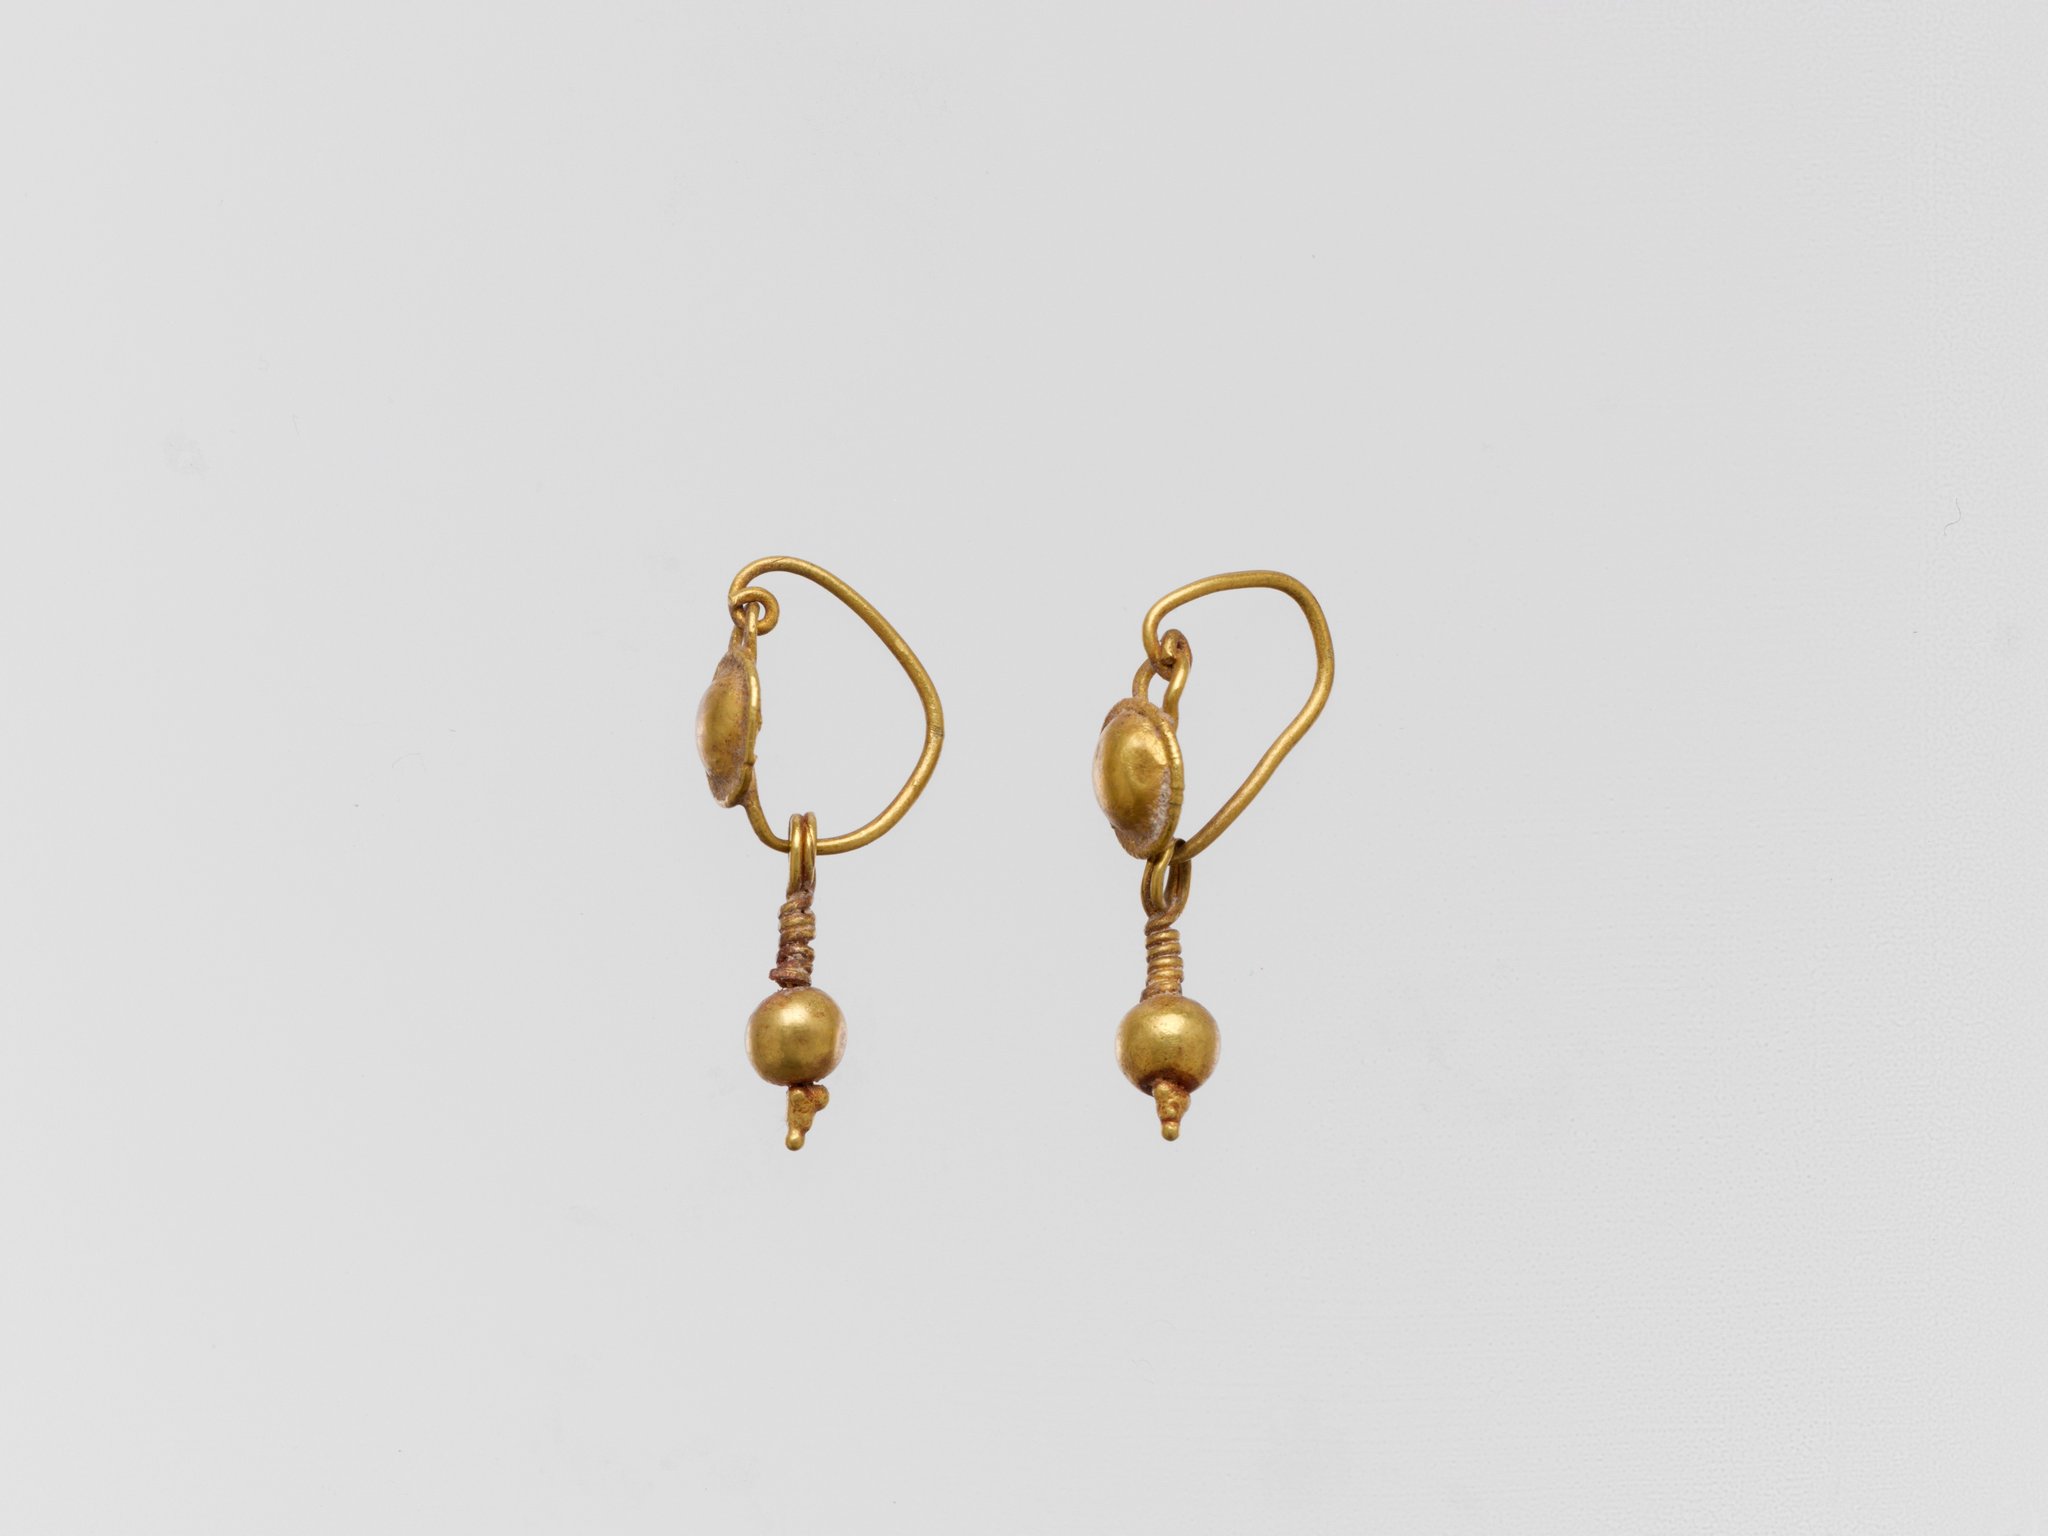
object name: earring with pendant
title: Gold earring with disc and pendant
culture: roman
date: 101-200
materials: gold